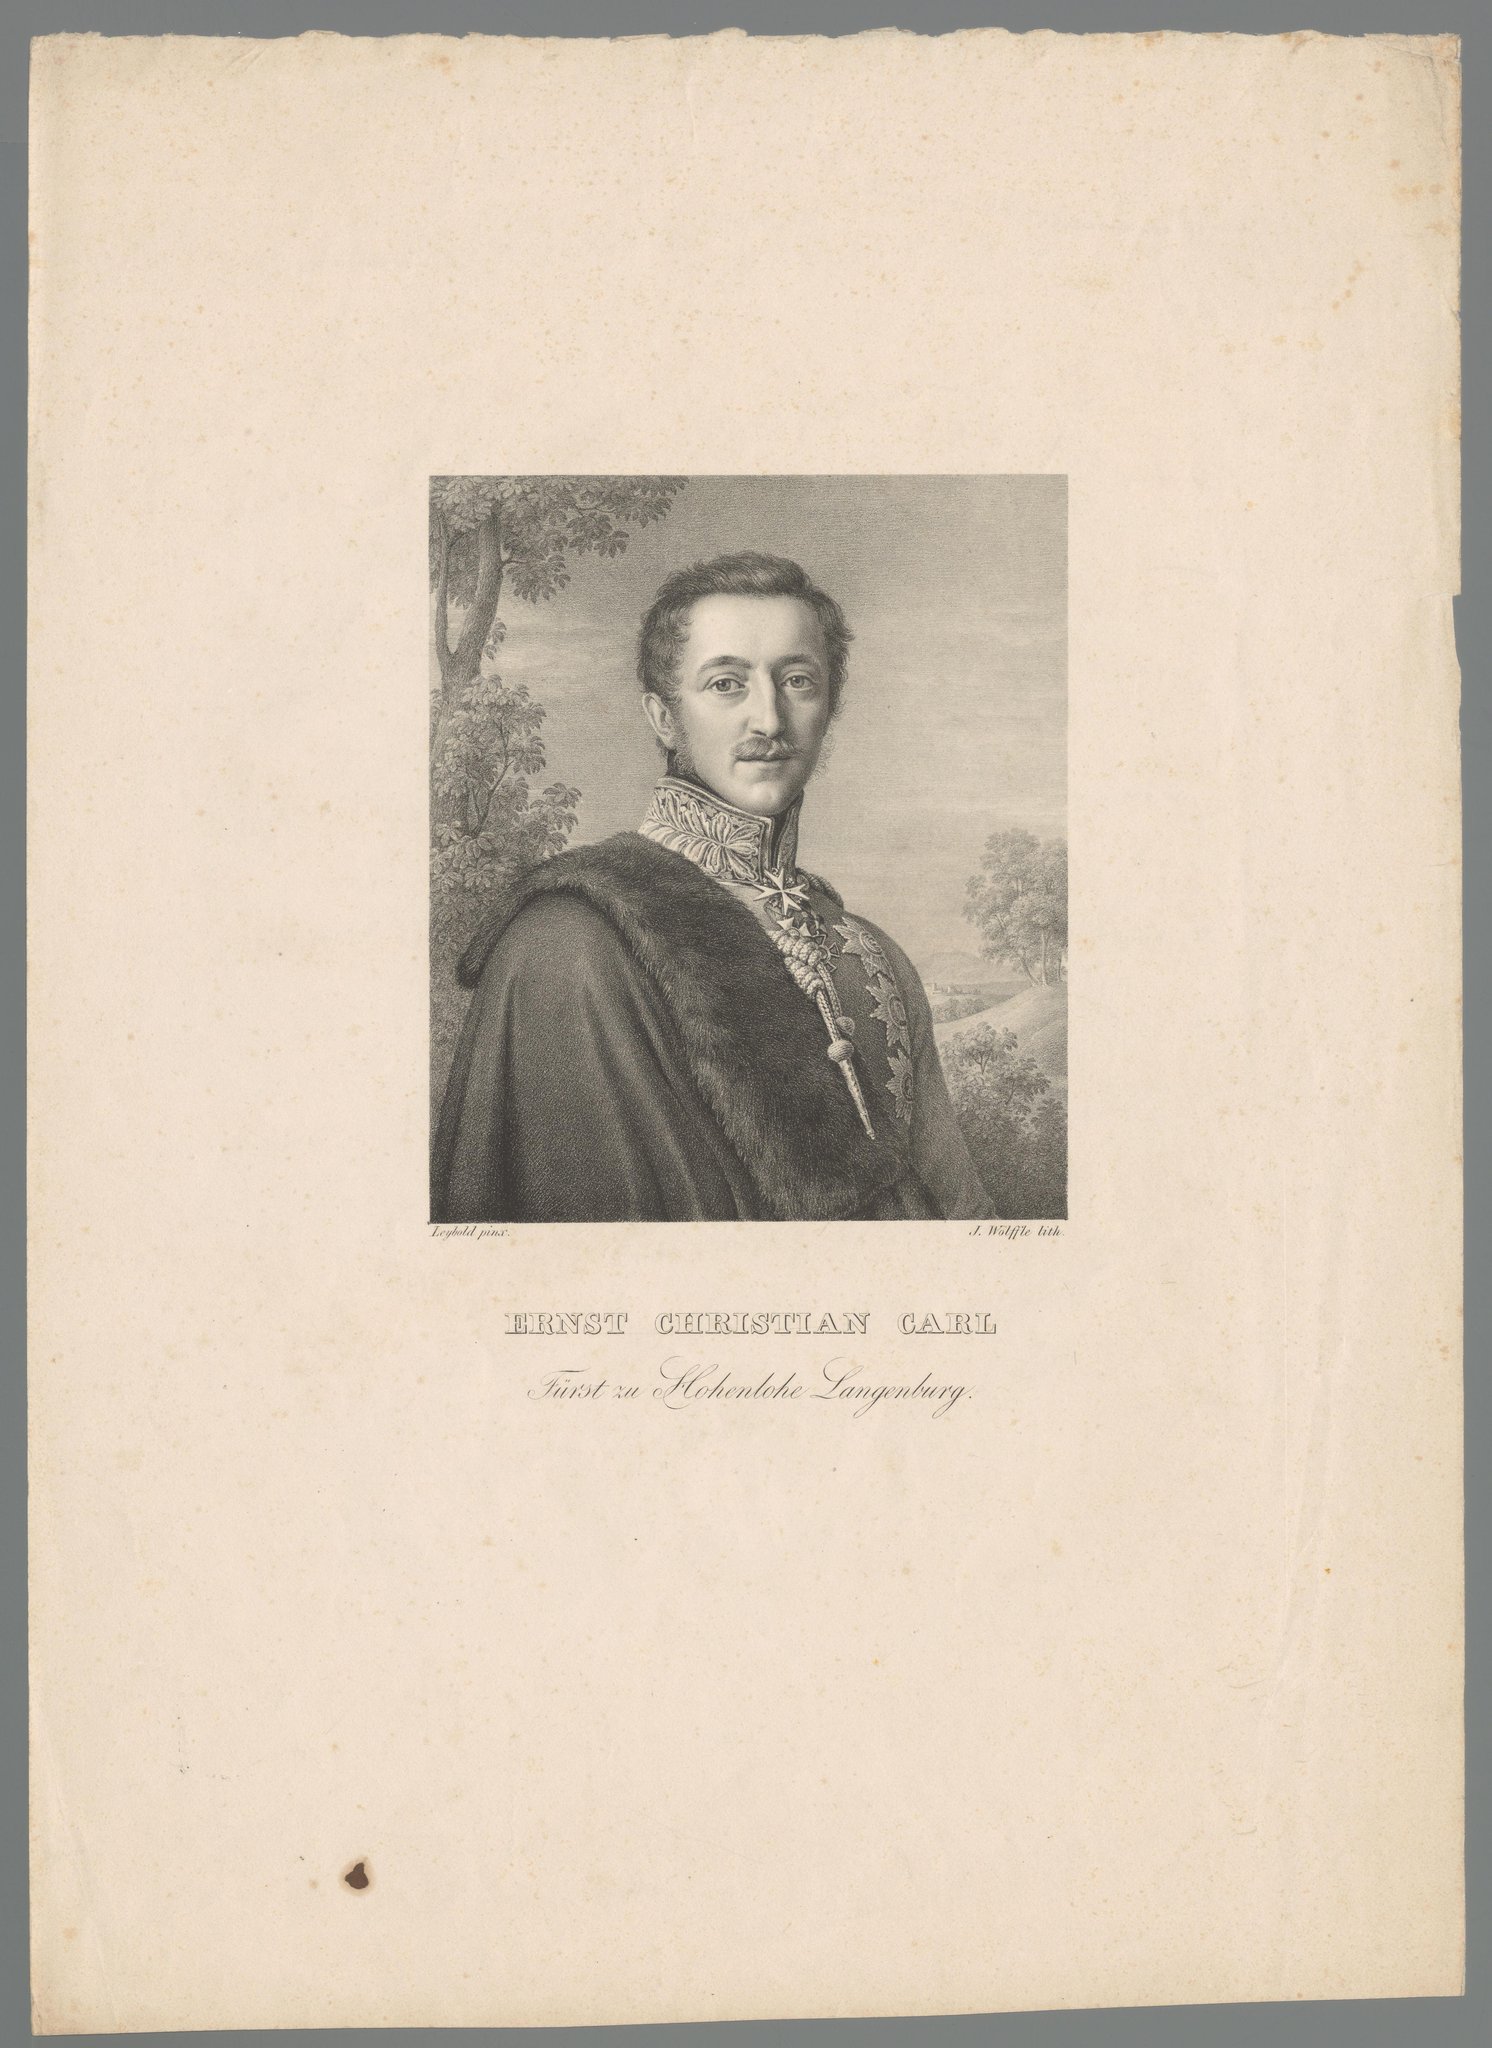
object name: print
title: Ernst Christian Carl, Fürst zu Hohenlohe Langenburg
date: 1817-1893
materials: paper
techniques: lithograph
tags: moustache, adult man, historical persons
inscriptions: collector's mark: Lugt 2228